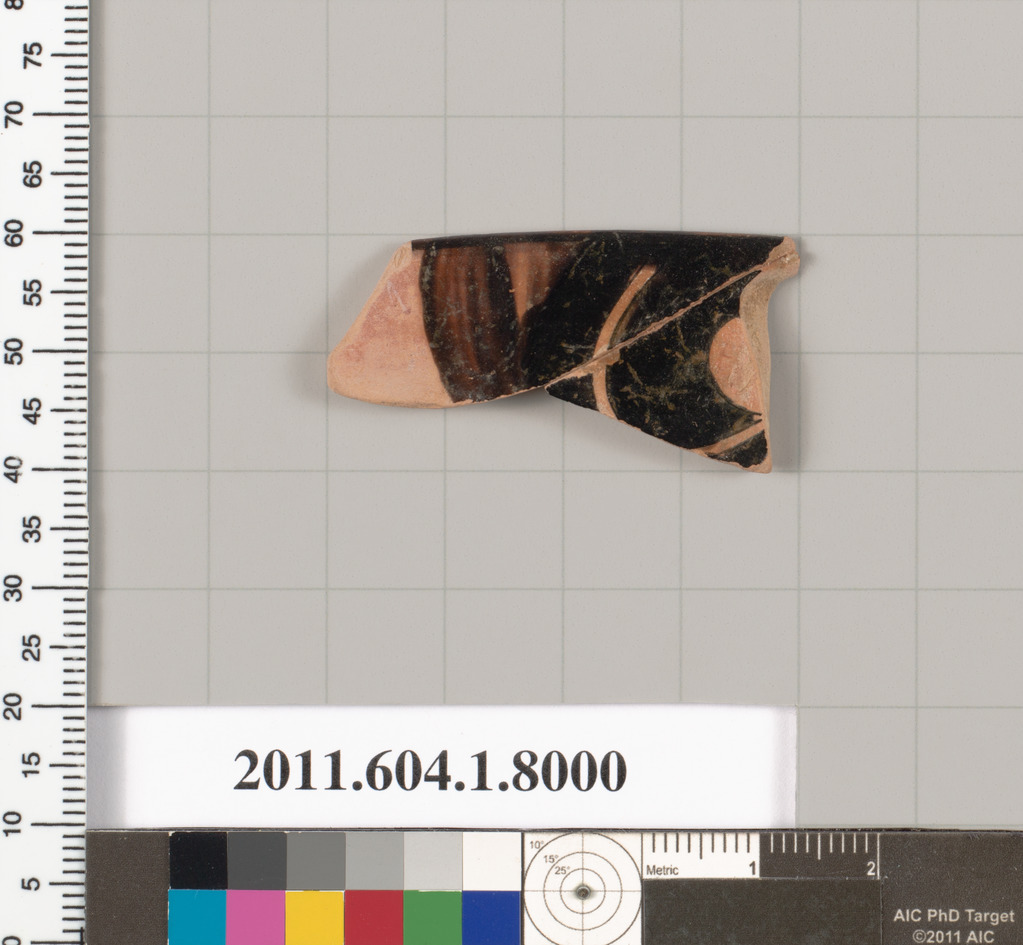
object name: kylix fragment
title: Terracotta rim fragment of a kylix (drinking cup)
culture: greek, attic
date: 460-450 BCE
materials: terracotta